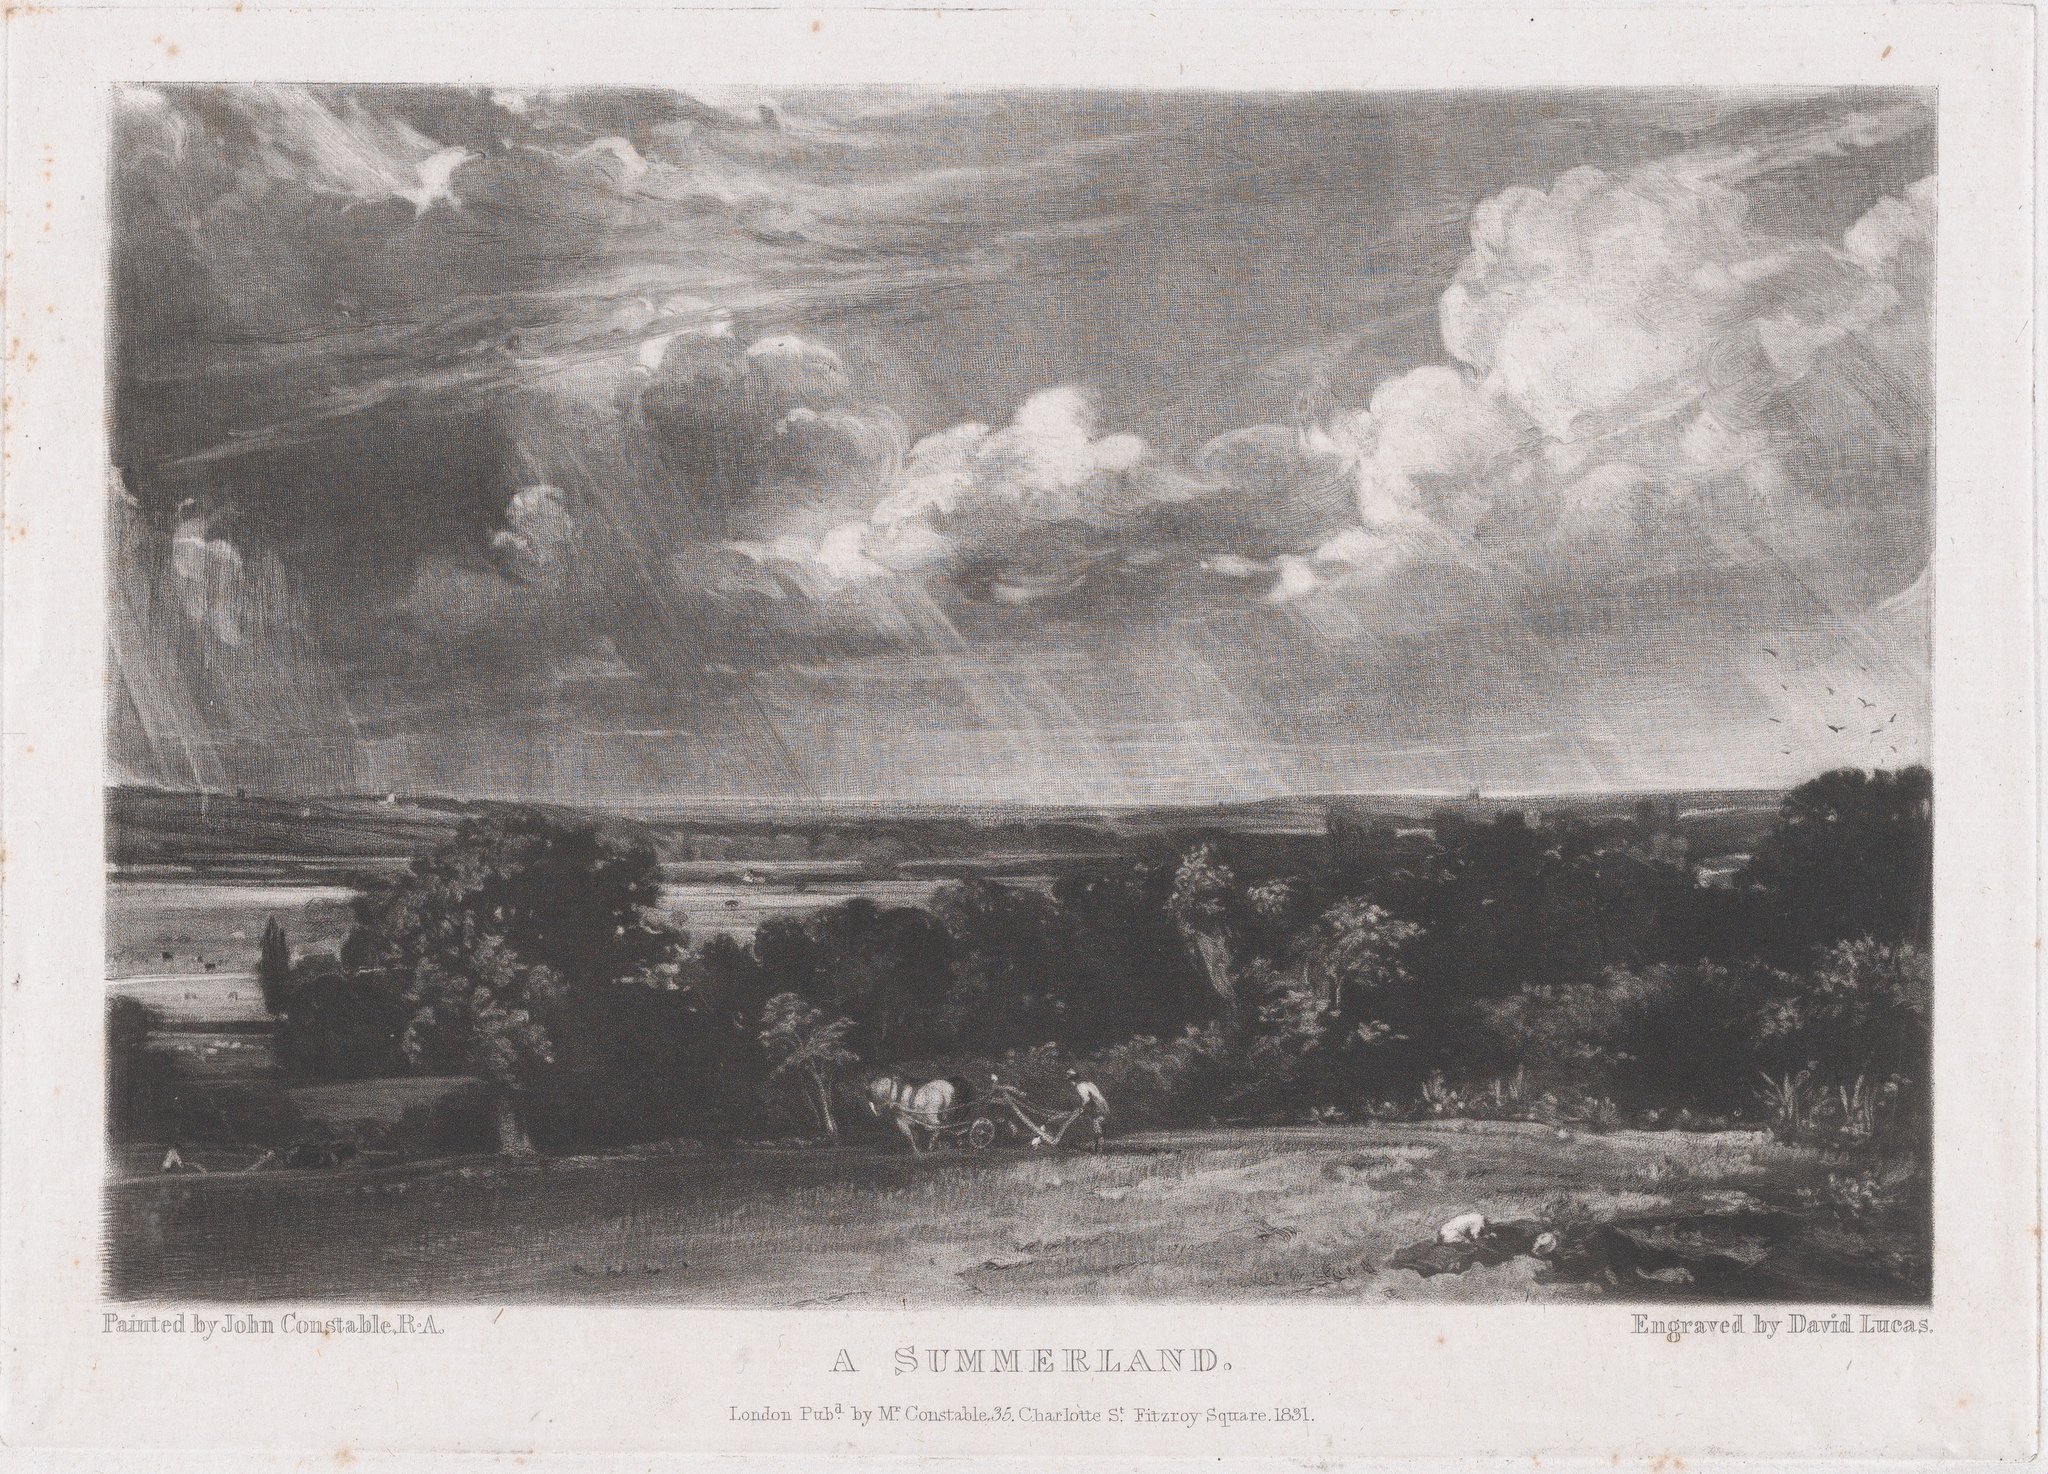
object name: print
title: A Summerland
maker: david lucas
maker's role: artist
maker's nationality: british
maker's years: 1802-1881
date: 1831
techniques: mezzotint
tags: men,landscapes,summer,working